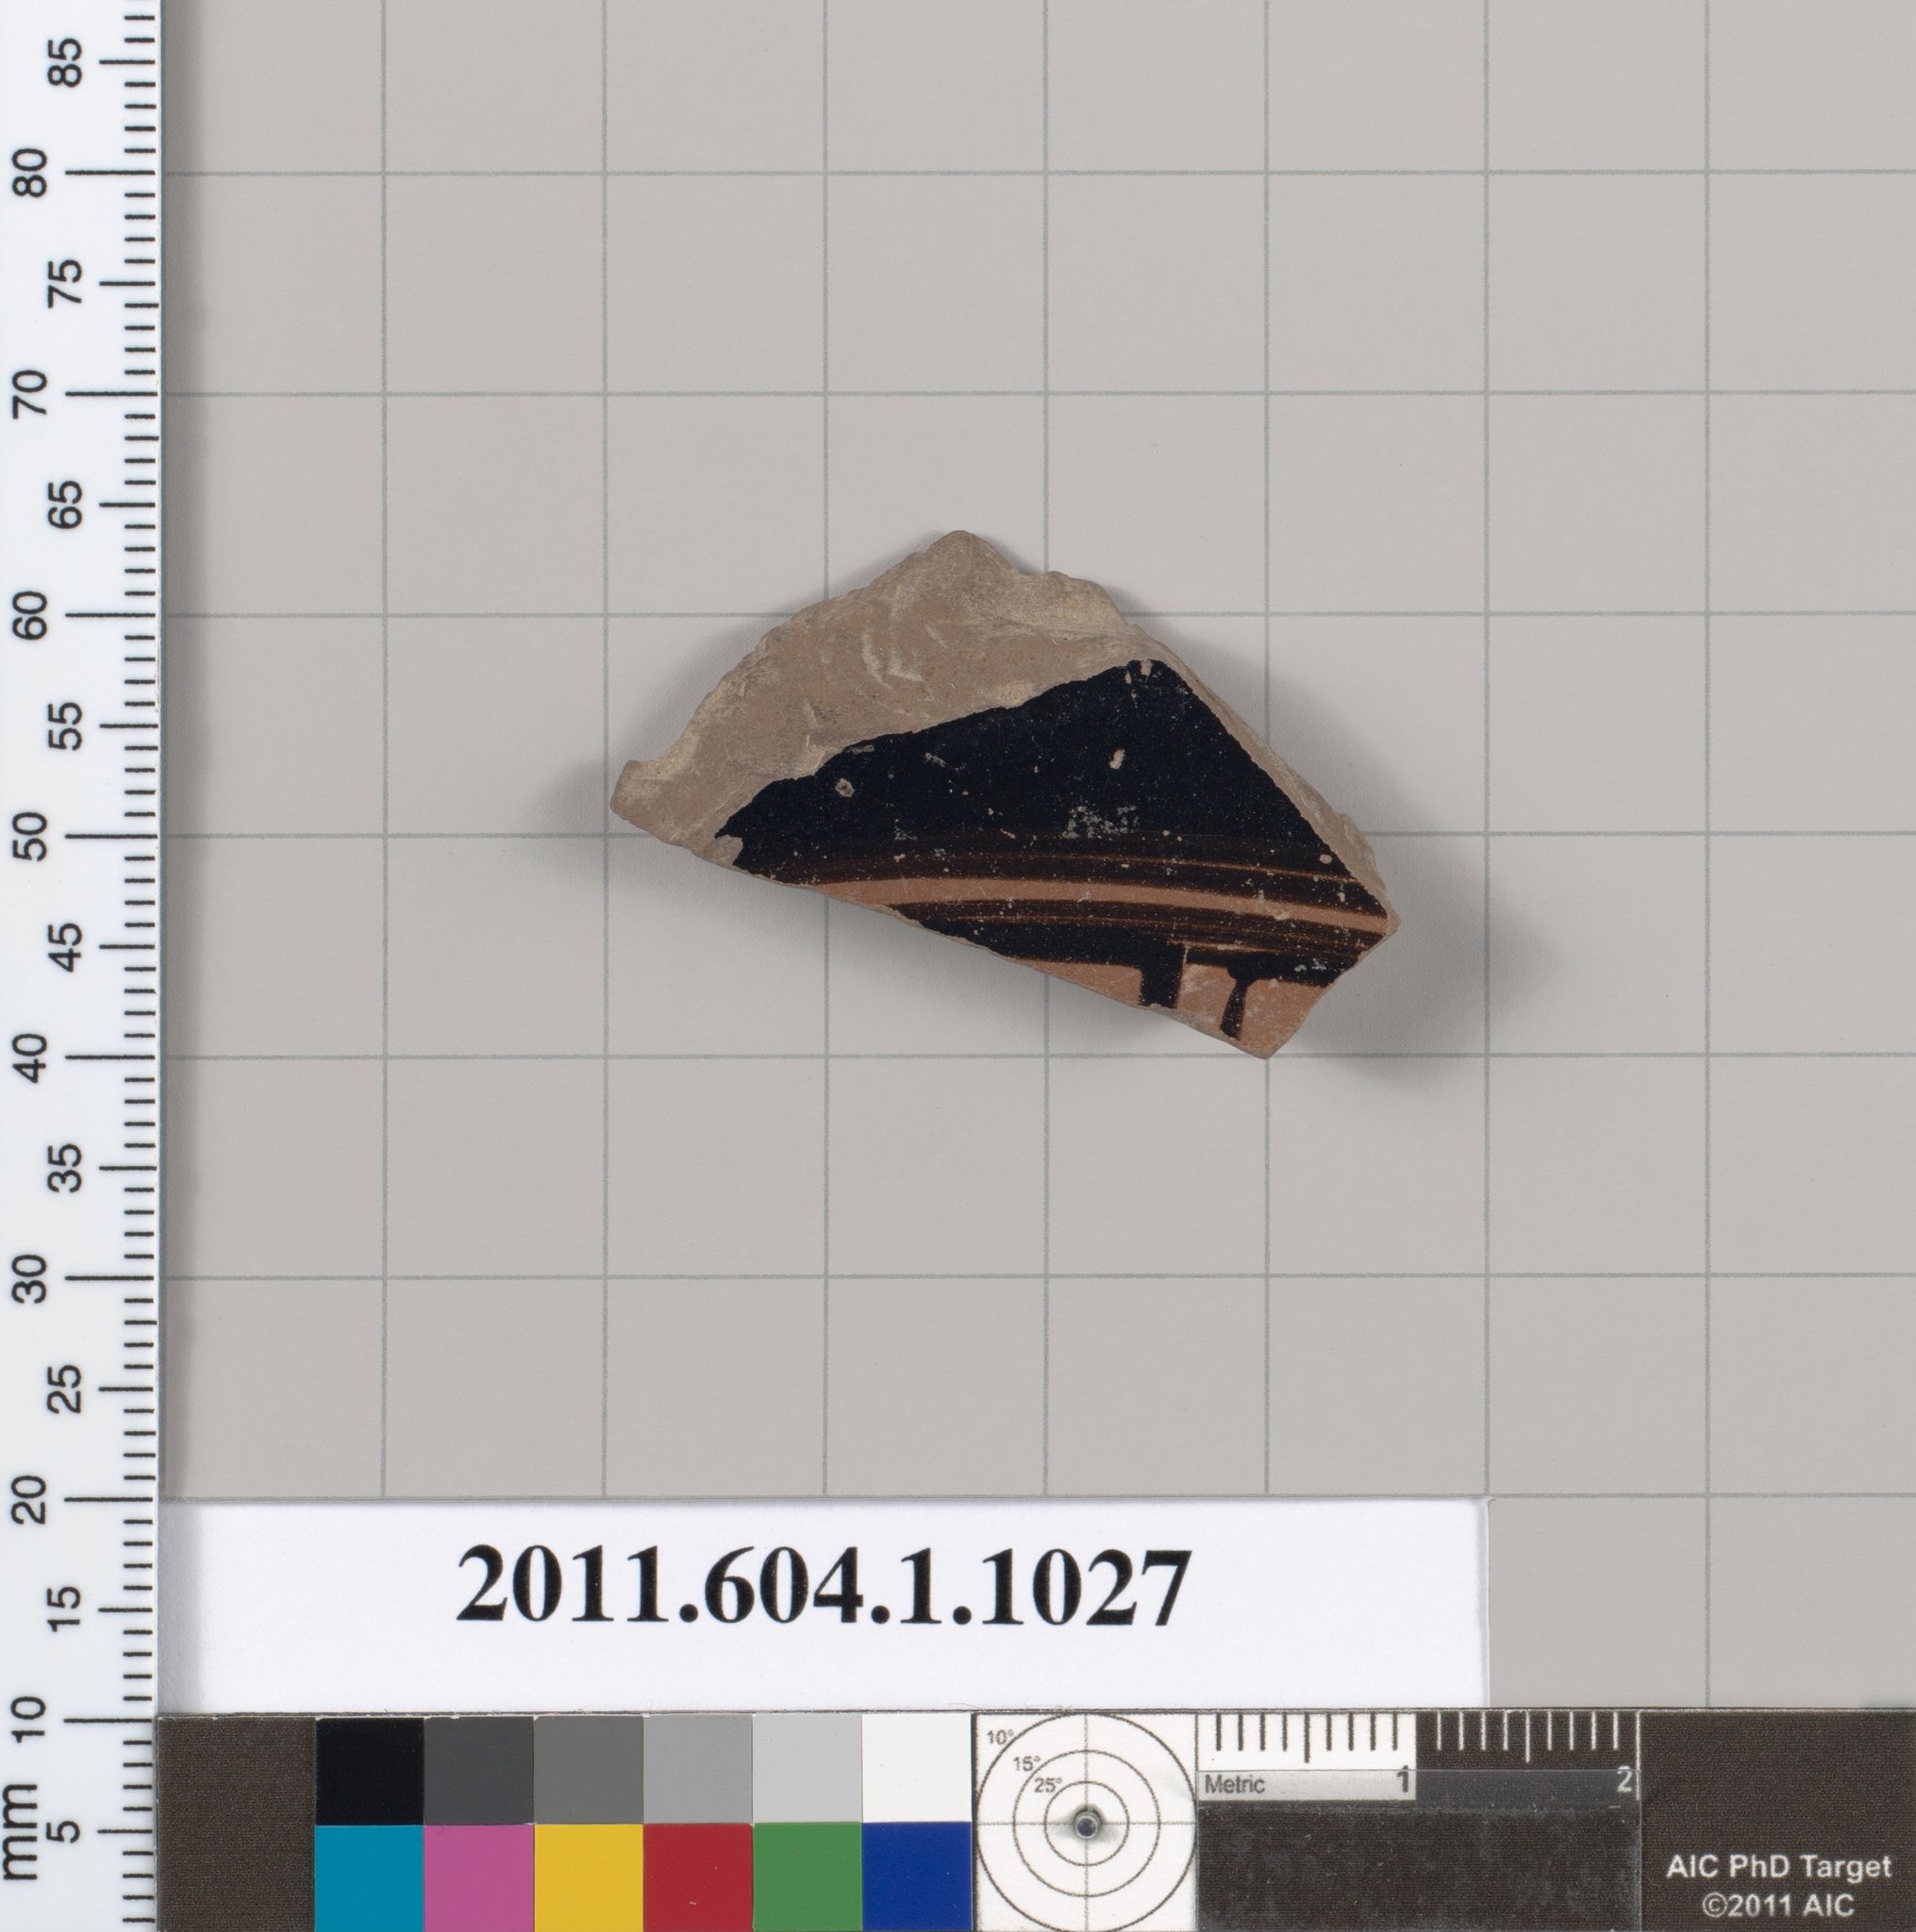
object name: kylix fragment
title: Terracotta fragment of a kylix (drinking cup)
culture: greek, attic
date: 475-451 BCE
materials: terracotta